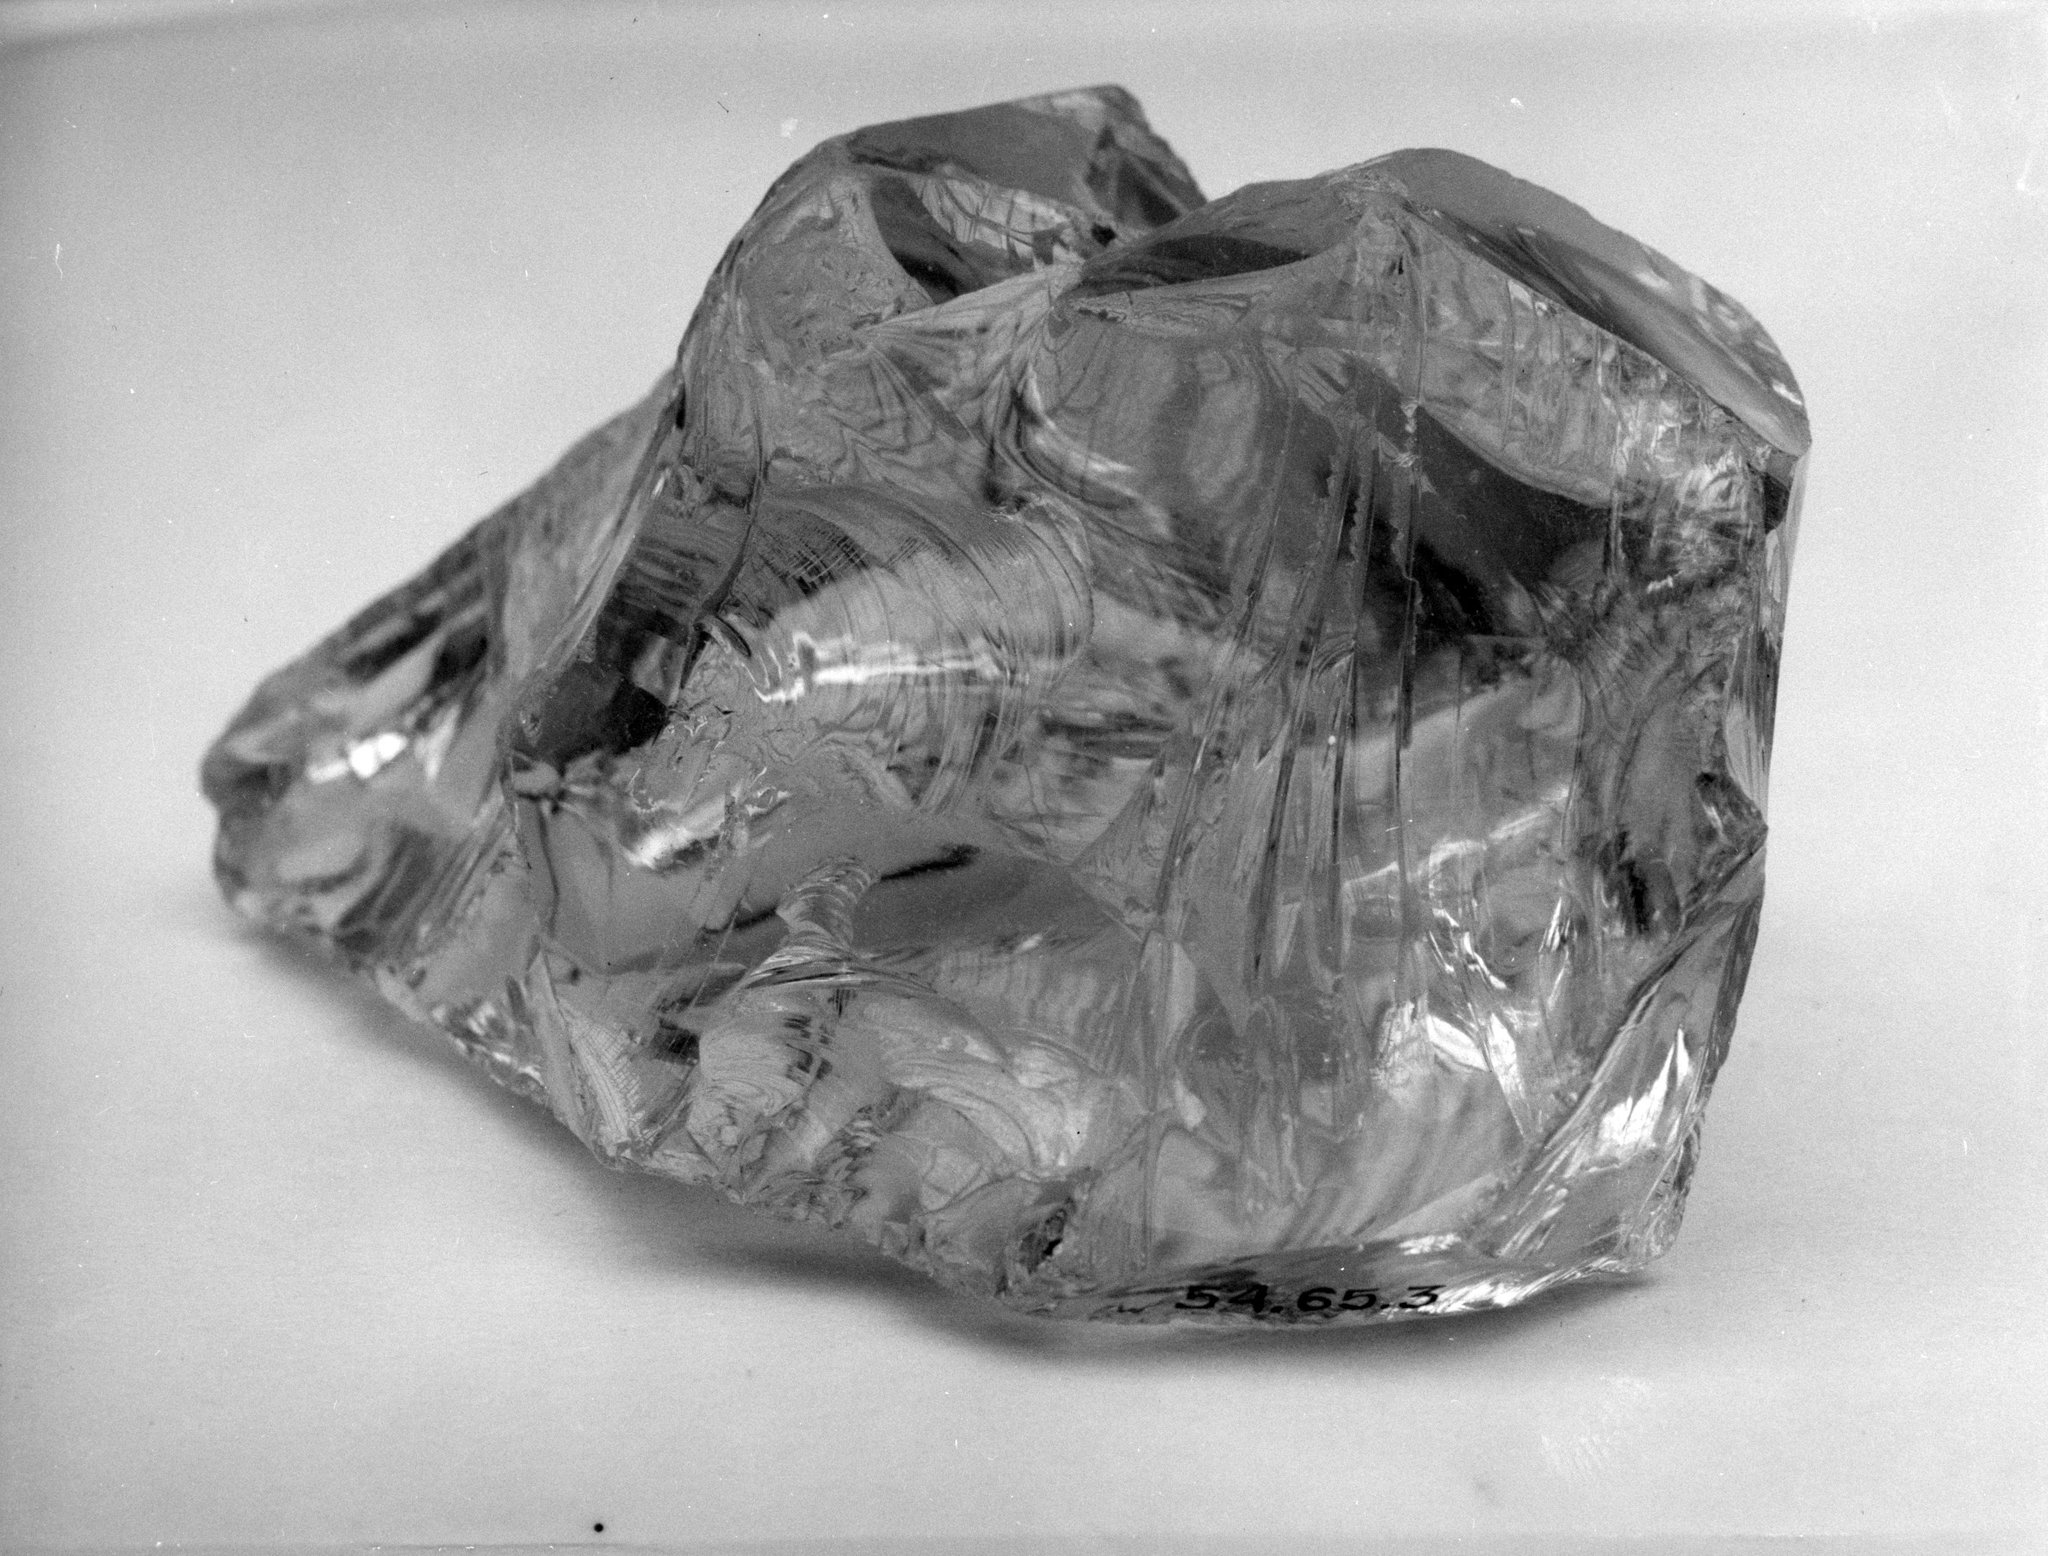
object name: fragment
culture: american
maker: redwood glass company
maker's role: maker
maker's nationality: american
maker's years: 1828-1868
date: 1828-1868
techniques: glassblowing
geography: united states